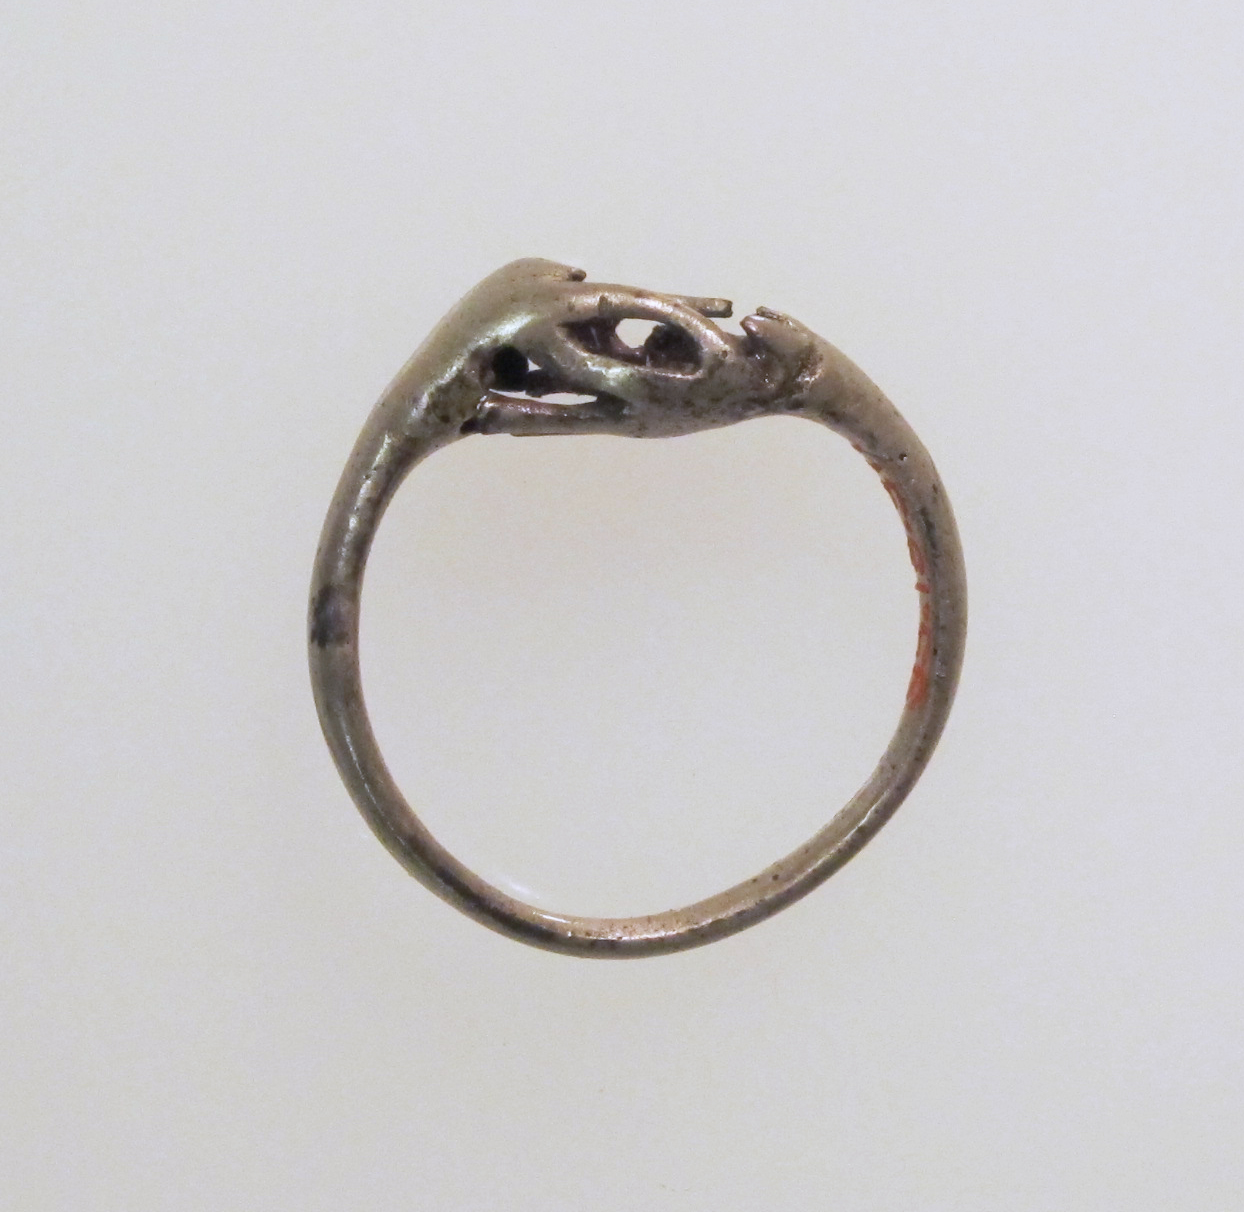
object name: ring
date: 7000 BCE-330 CE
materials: silver